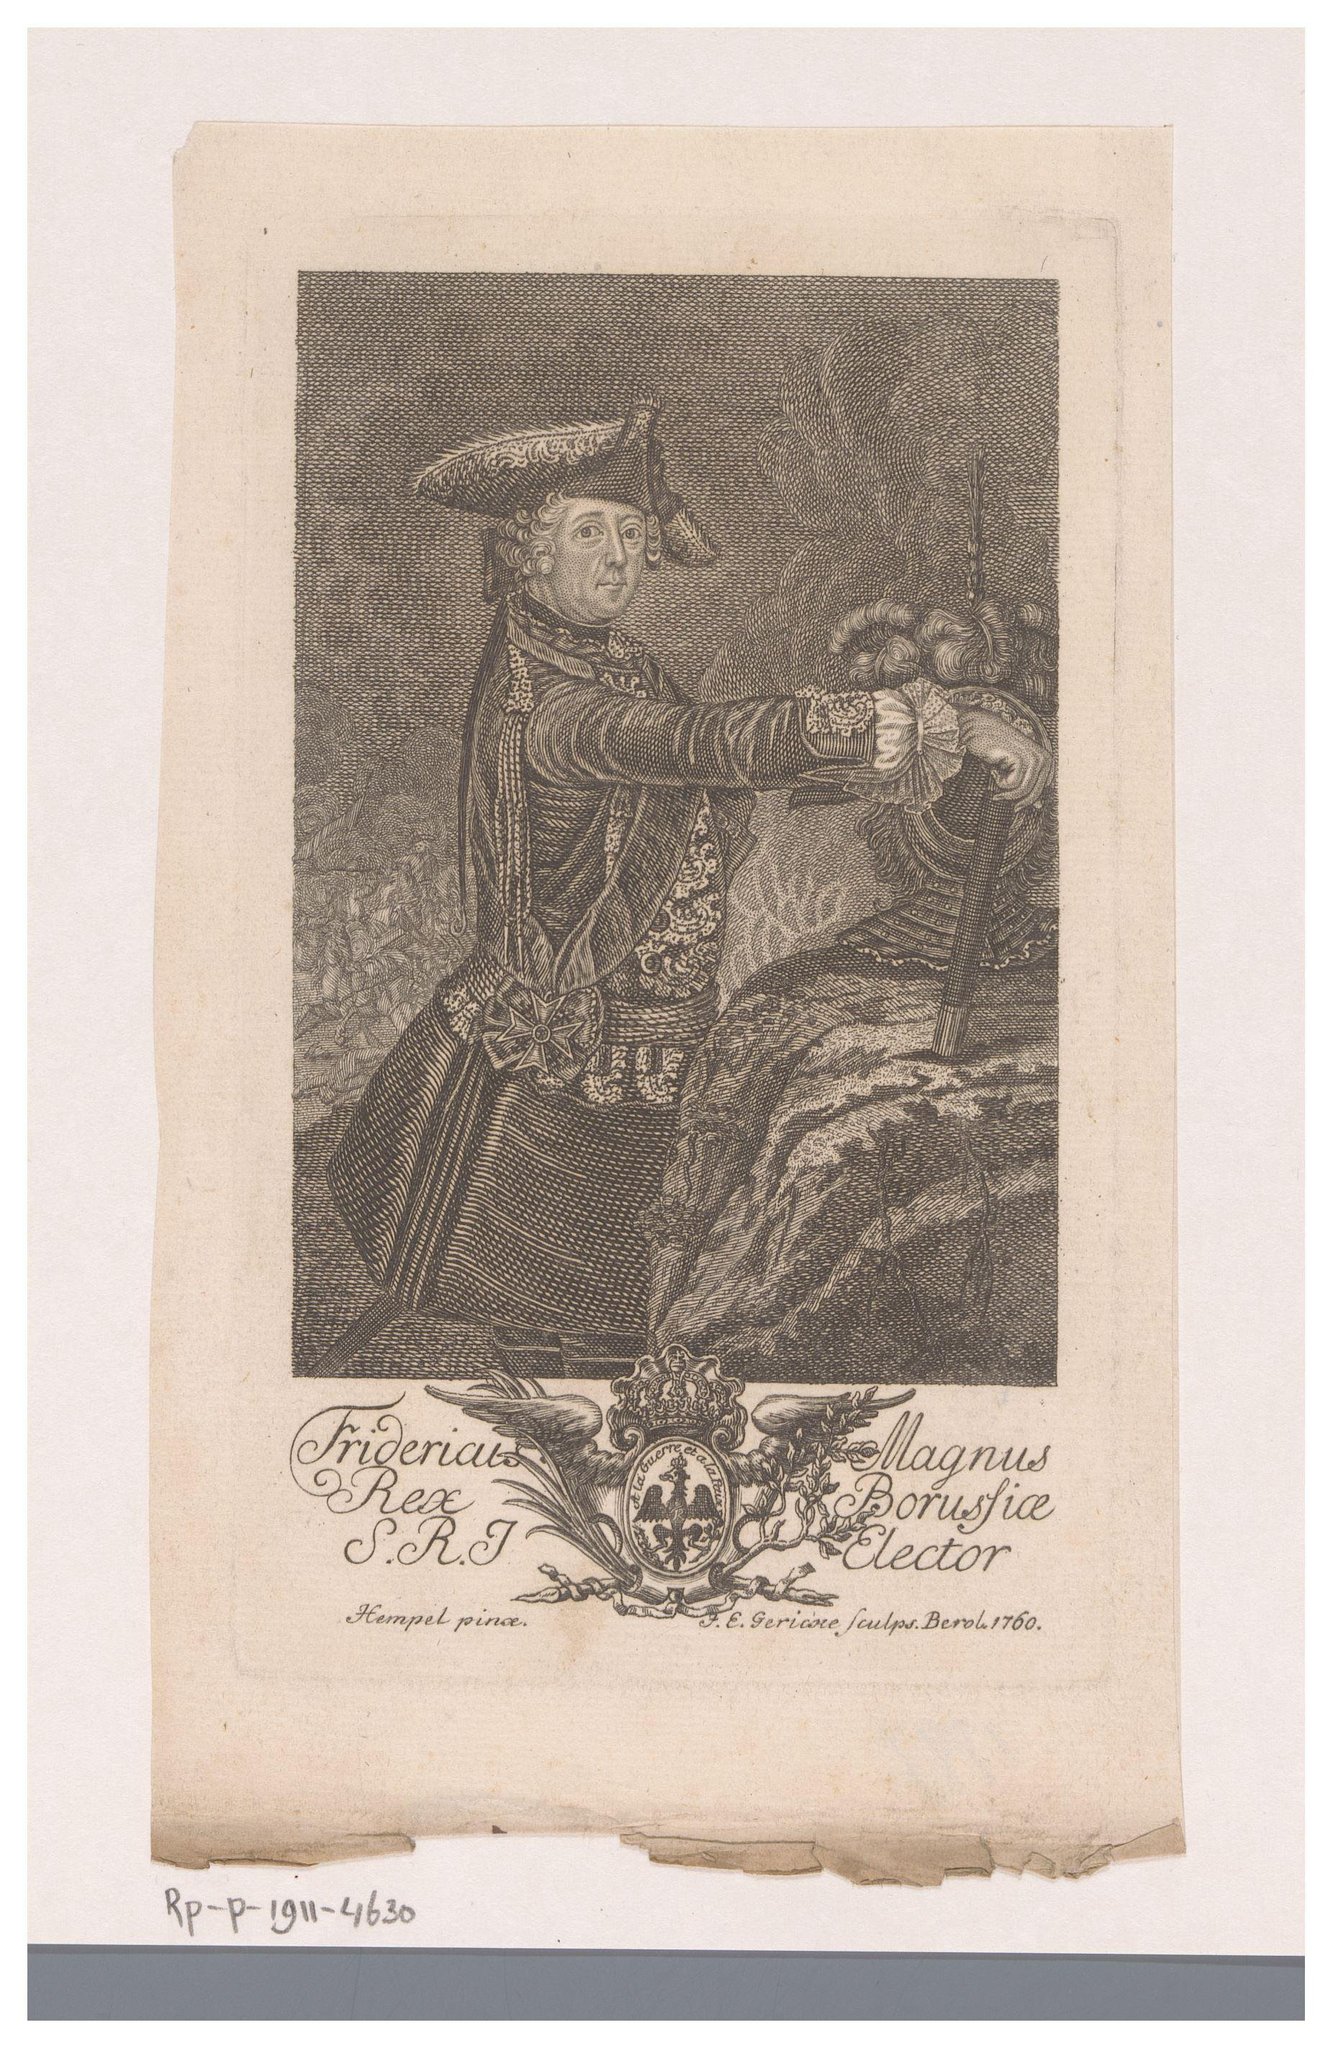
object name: print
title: Portret van Frederik de Grote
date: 1760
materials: paper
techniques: engraving, etching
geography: berlin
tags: berlin, frederick ii (king of prussia), helmet, knighthood order, historical persons, emperor, baton of general, armorial bearing, heraldry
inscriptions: collector's mark: Lugt 2228